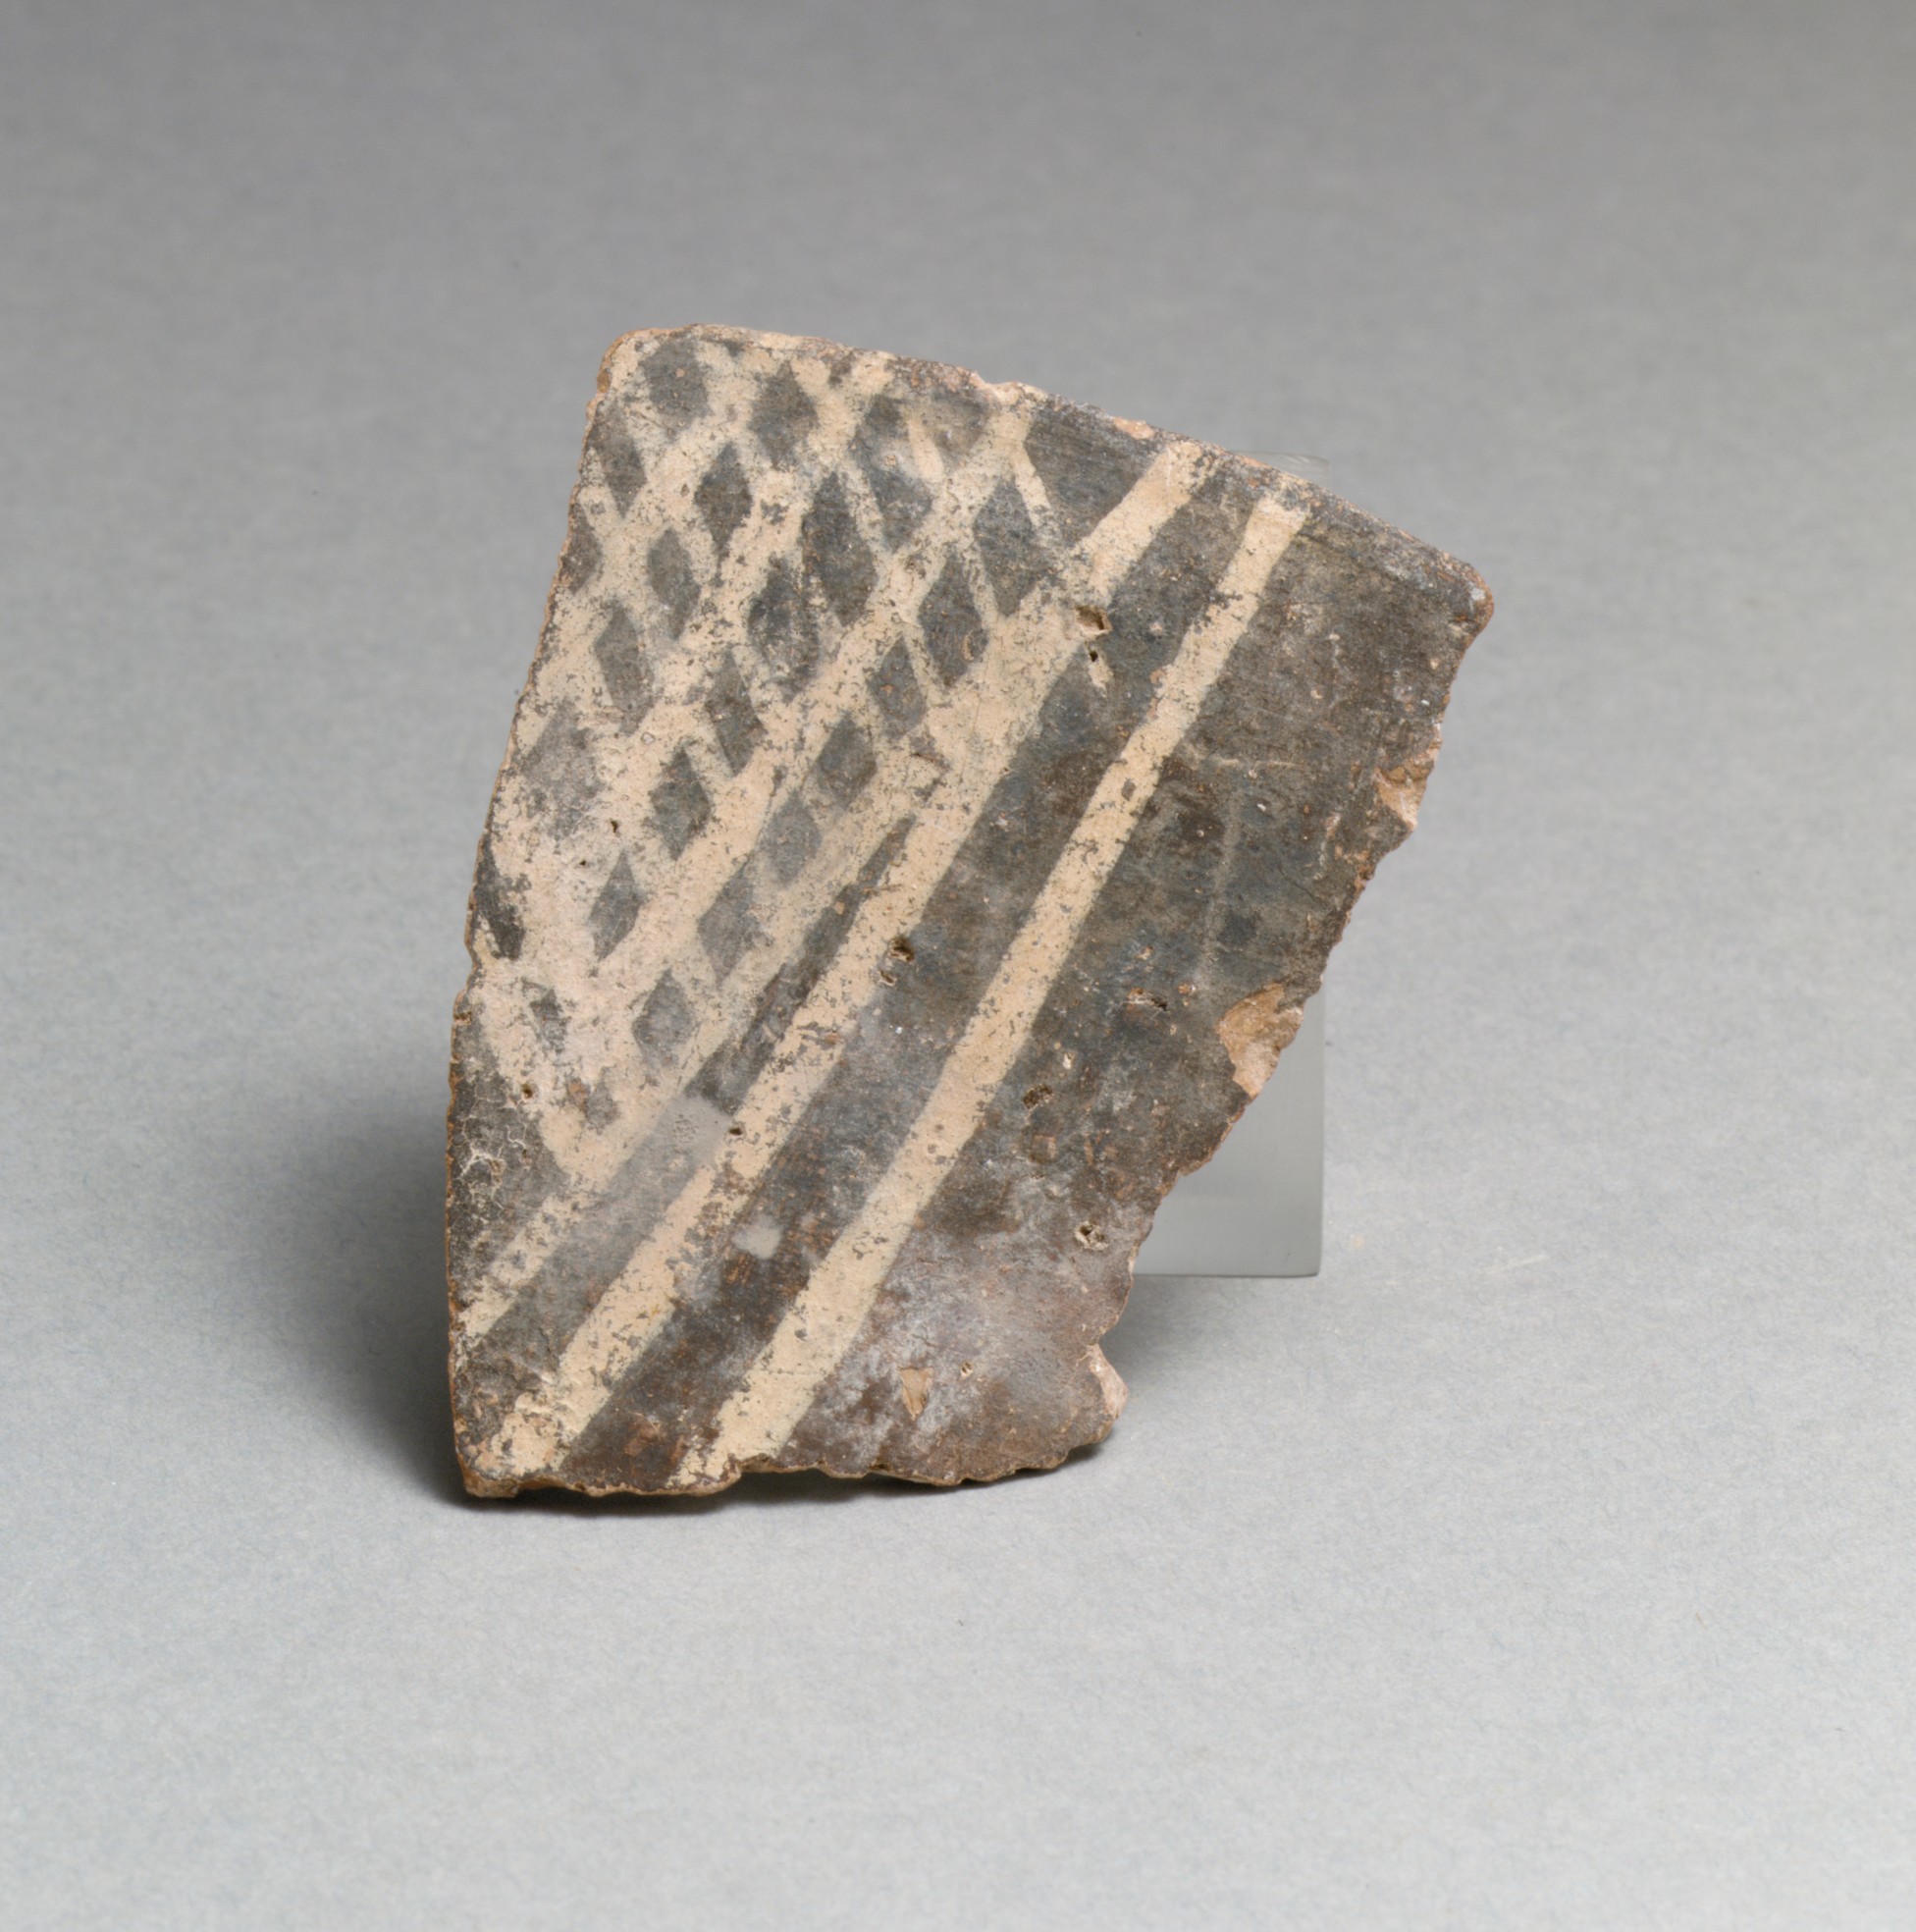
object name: vase fragment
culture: minoan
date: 2600-2000 BCE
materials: terracotta